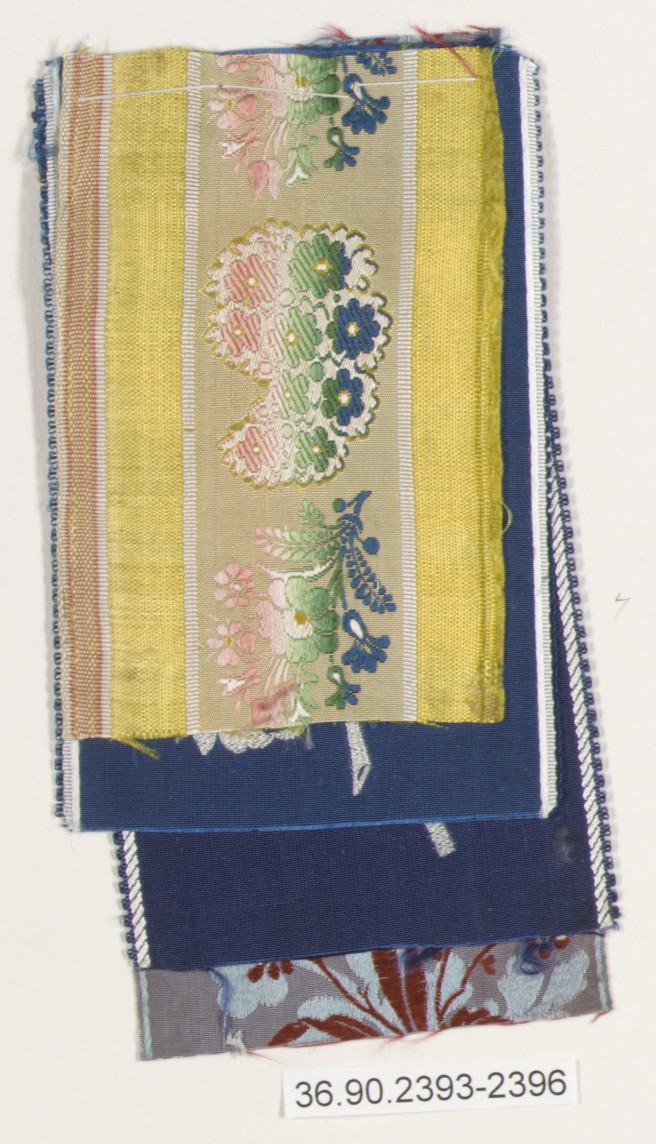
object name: ribbon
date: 1801-1900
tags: flowers